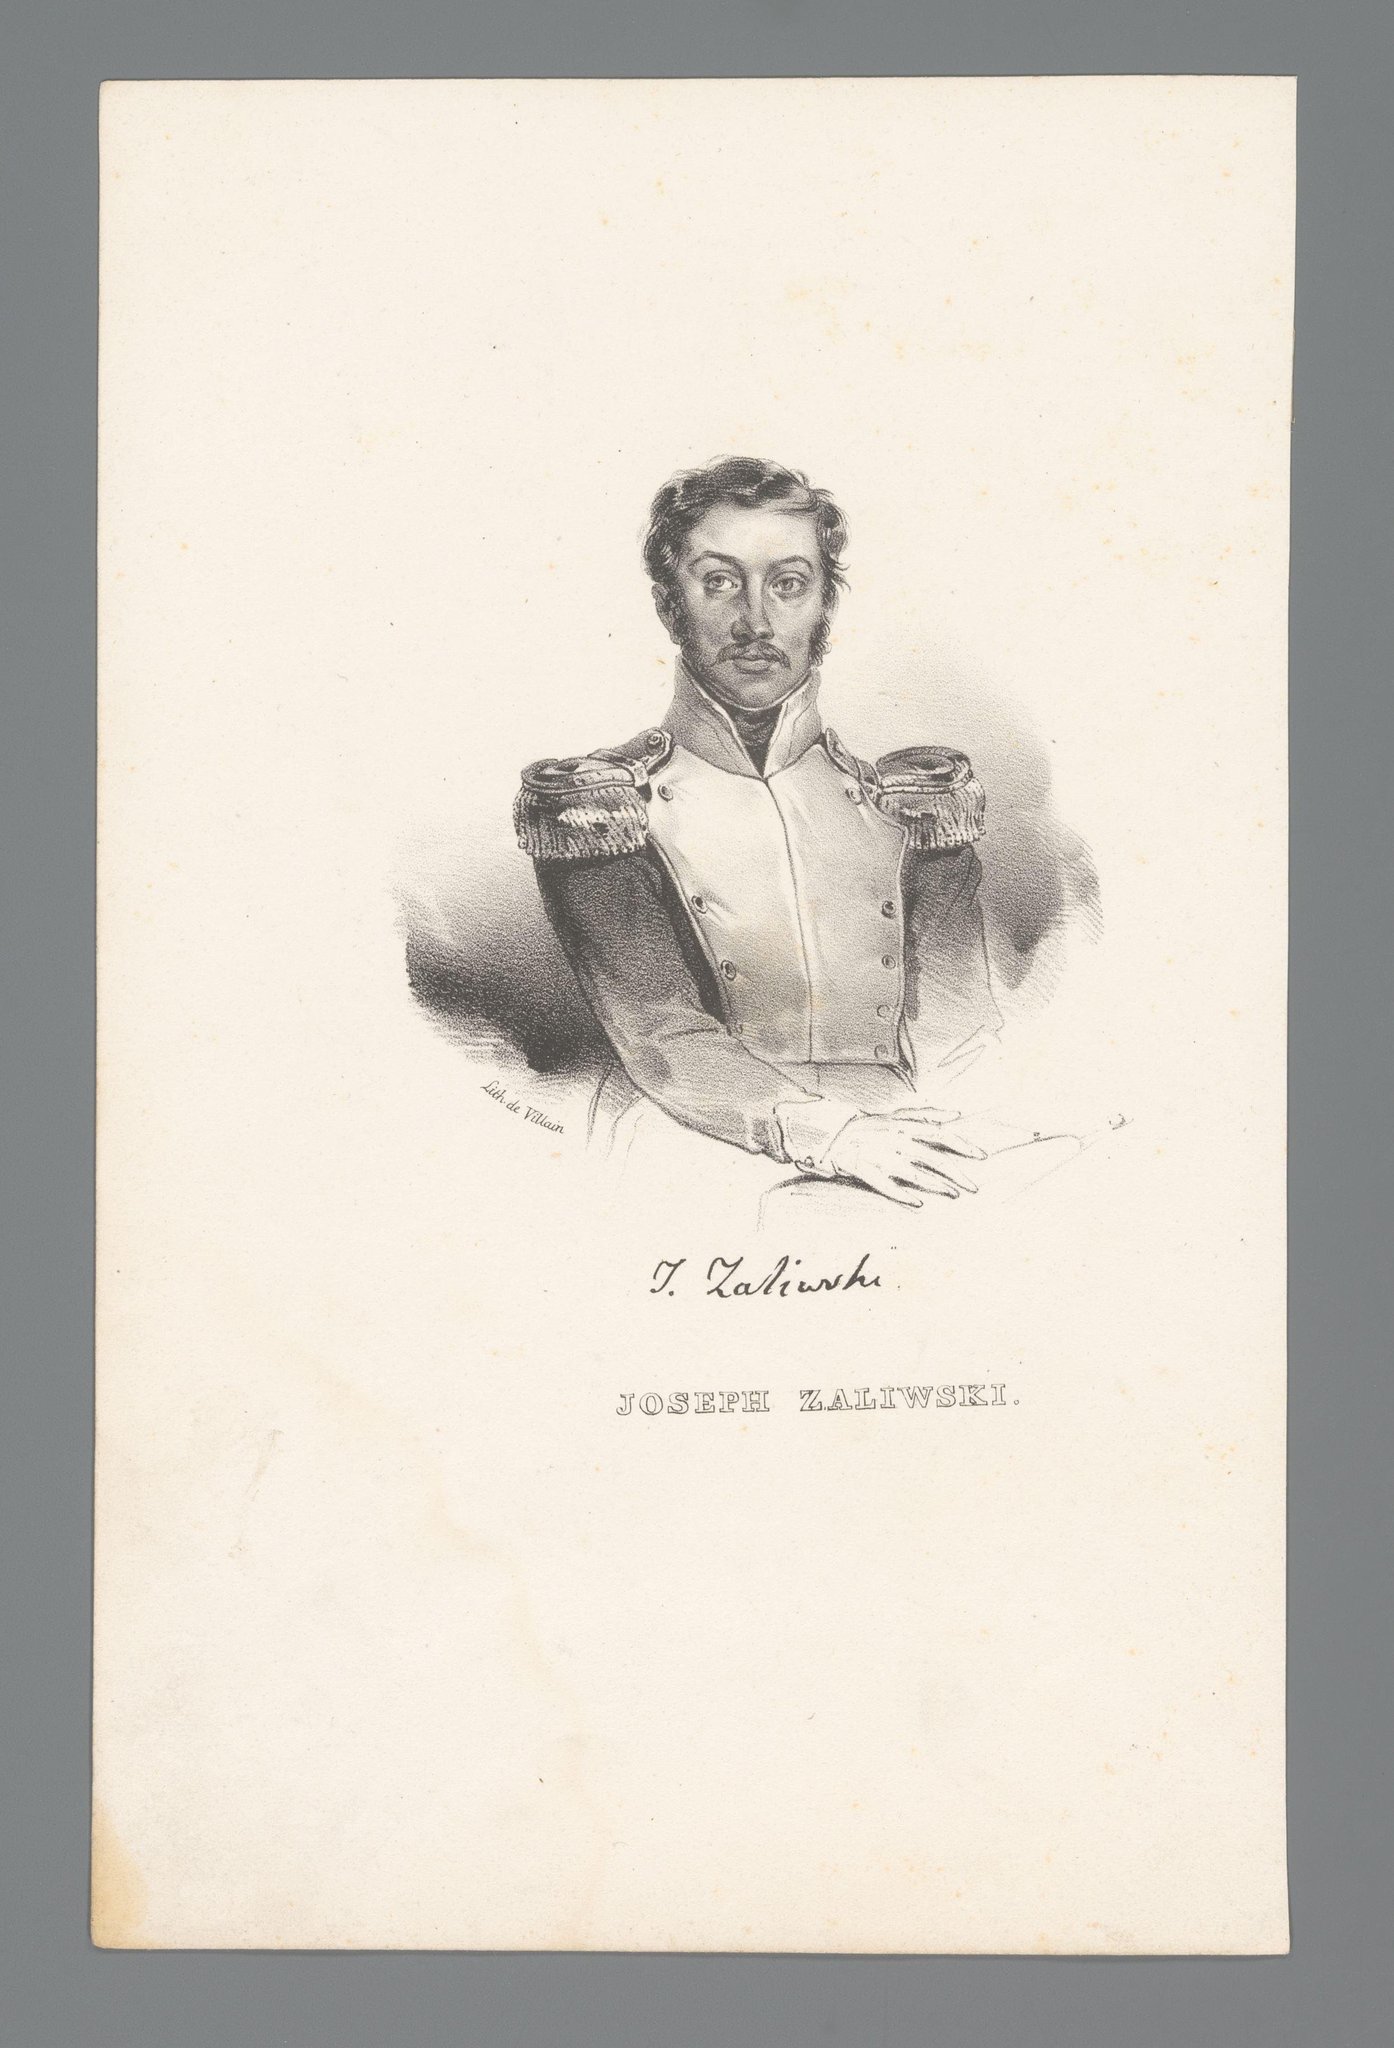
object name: print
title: Joseph Zaliwski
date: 1832-1839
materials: paper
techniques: lithograph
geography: paris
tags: historical persons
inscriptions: collector's mark: Lugt 2228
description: Prent uit: Straszewicz., Joseph. Les polonais et les polonaises de la révolution du 29 novembre 1830, ou Portraits des personnes qui ont figuré dans la dernière guerre de l'indépendance polonaise, avec les fac-simile de leur signature, lithographiés sur dessins originaux, par les artistes les plus distingués: MM. Grévedon, Maurin, Vigneron, Belliard, Devéria, Bazin, Desmadryl, Lecler, Desmaisons, Rutowski, officier polonais, etc,. etc., accompagnés d'une biographie pour chaque portrait. Parijs: Catherine-Anaïs Pinard, 1832. Of uit: Straszewicz., Joseph. Les polonais et les polonaises de la révolution du 29 novembre 1830. Biographie des personnes qui ont figuré dans la dernière guerre de l'indépendance polonaise, avec les fac-simile de leur signature, ornée de 30 portraits lithographiés sur dessins originaux, par les artistes les plus distingués: MM. Grévedon, Maurin, Vigneron, Belliard, Devéria, Bazin, Desmadryl, Lecler, etc., etc.. Parijs: s.n., 1839.